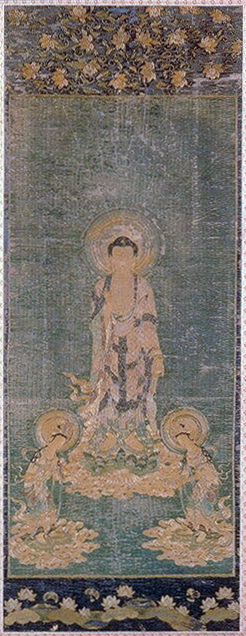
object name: panel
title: Welcoming Descent of Amida, the Buddha of Limitless Light, with Bodhisattvas Kannon and Seishi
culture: japanese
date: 1201-1300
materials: hair, panel, silk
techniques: embroidery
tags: bodhisattvas